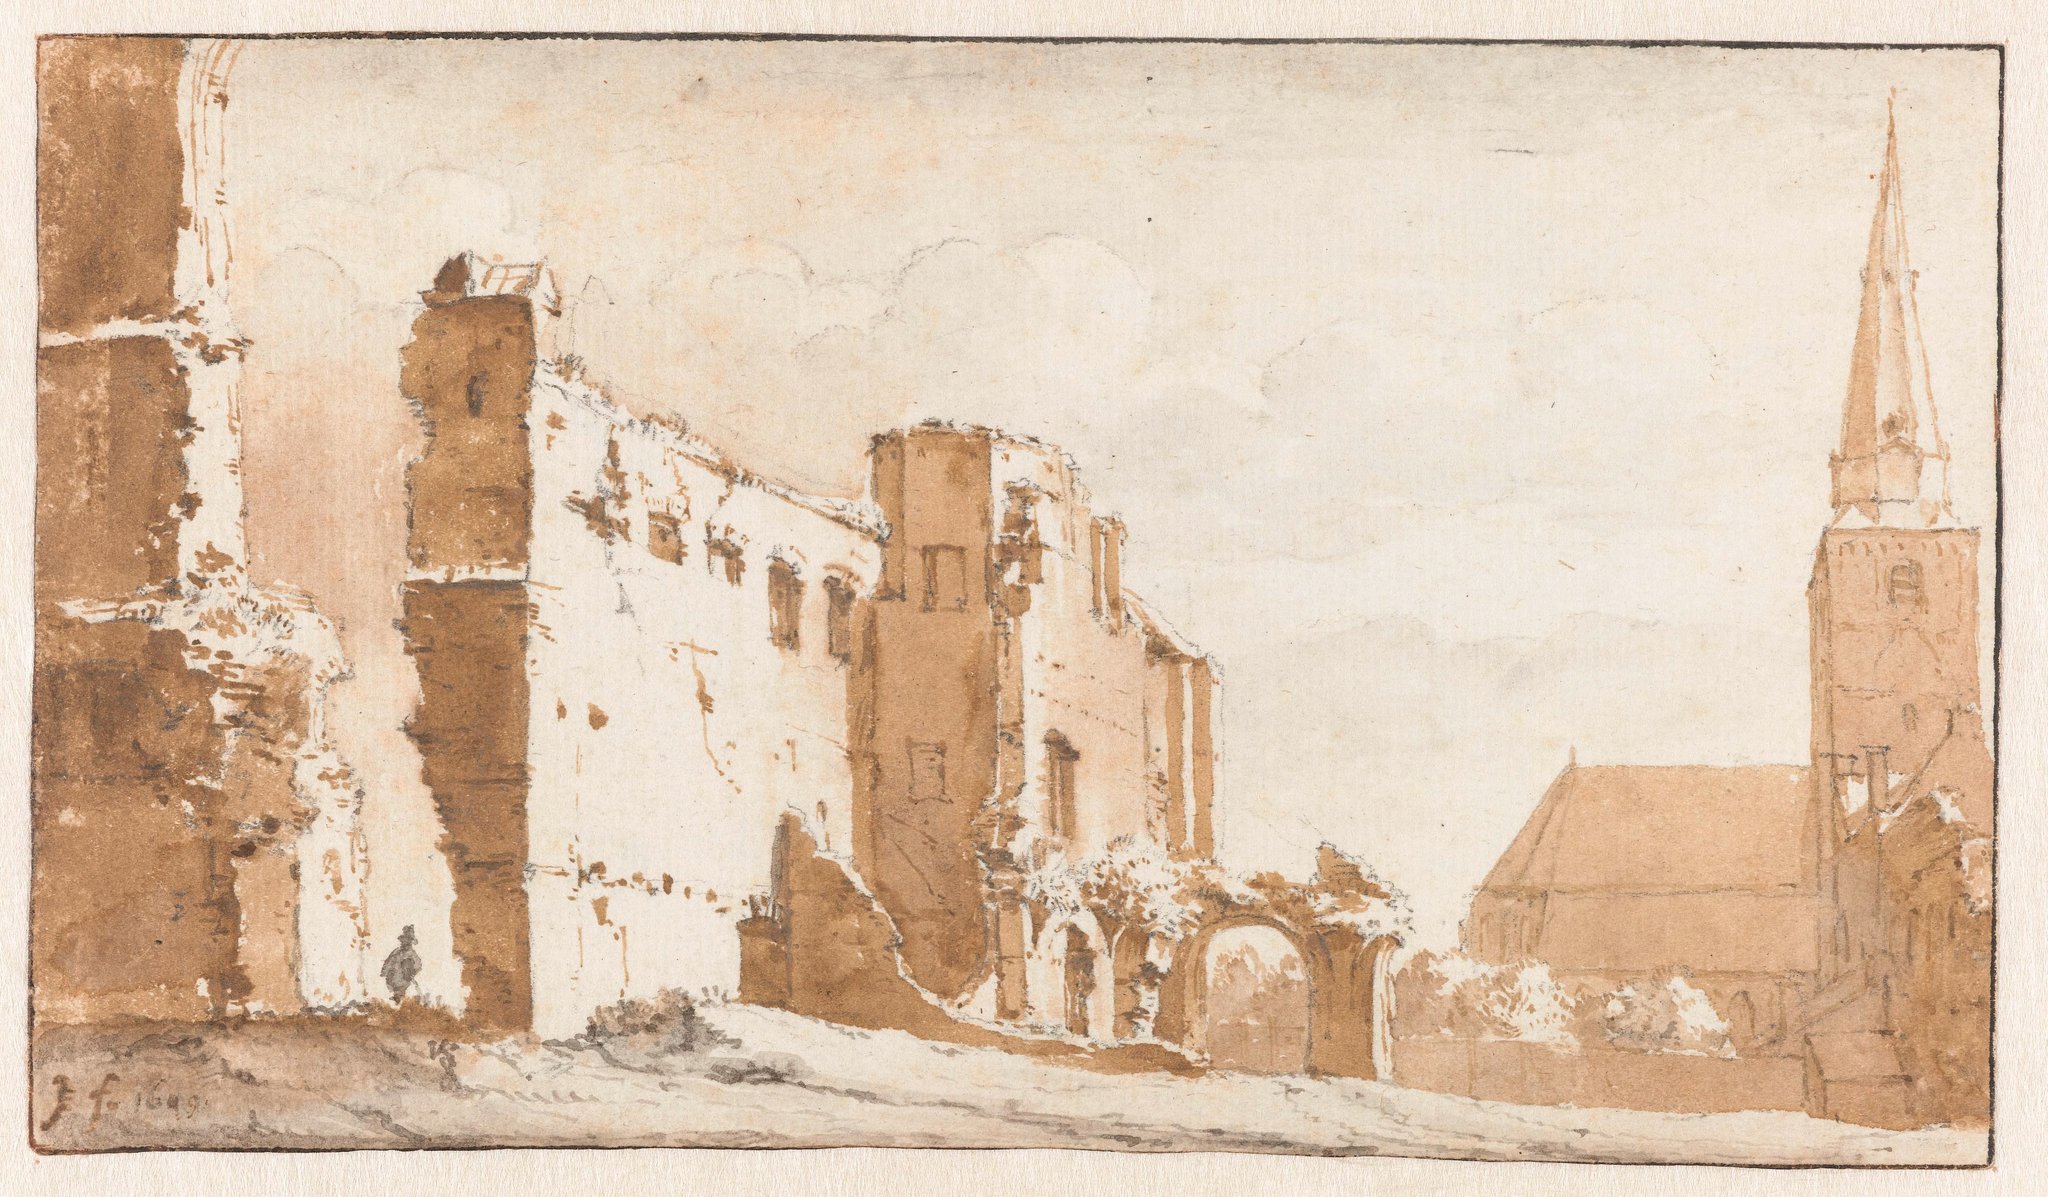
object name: drawing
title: Ruïne van de abdij en de kerk te Rijnsburg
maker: jan de bisschop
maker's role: draughtsman, print maker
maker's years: 1628-1671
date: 1649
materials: chalk, ink, paper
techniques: brush, pen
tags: abbey, monastery, convent ~ roman catholic church, church (exterior), landscape with ruins